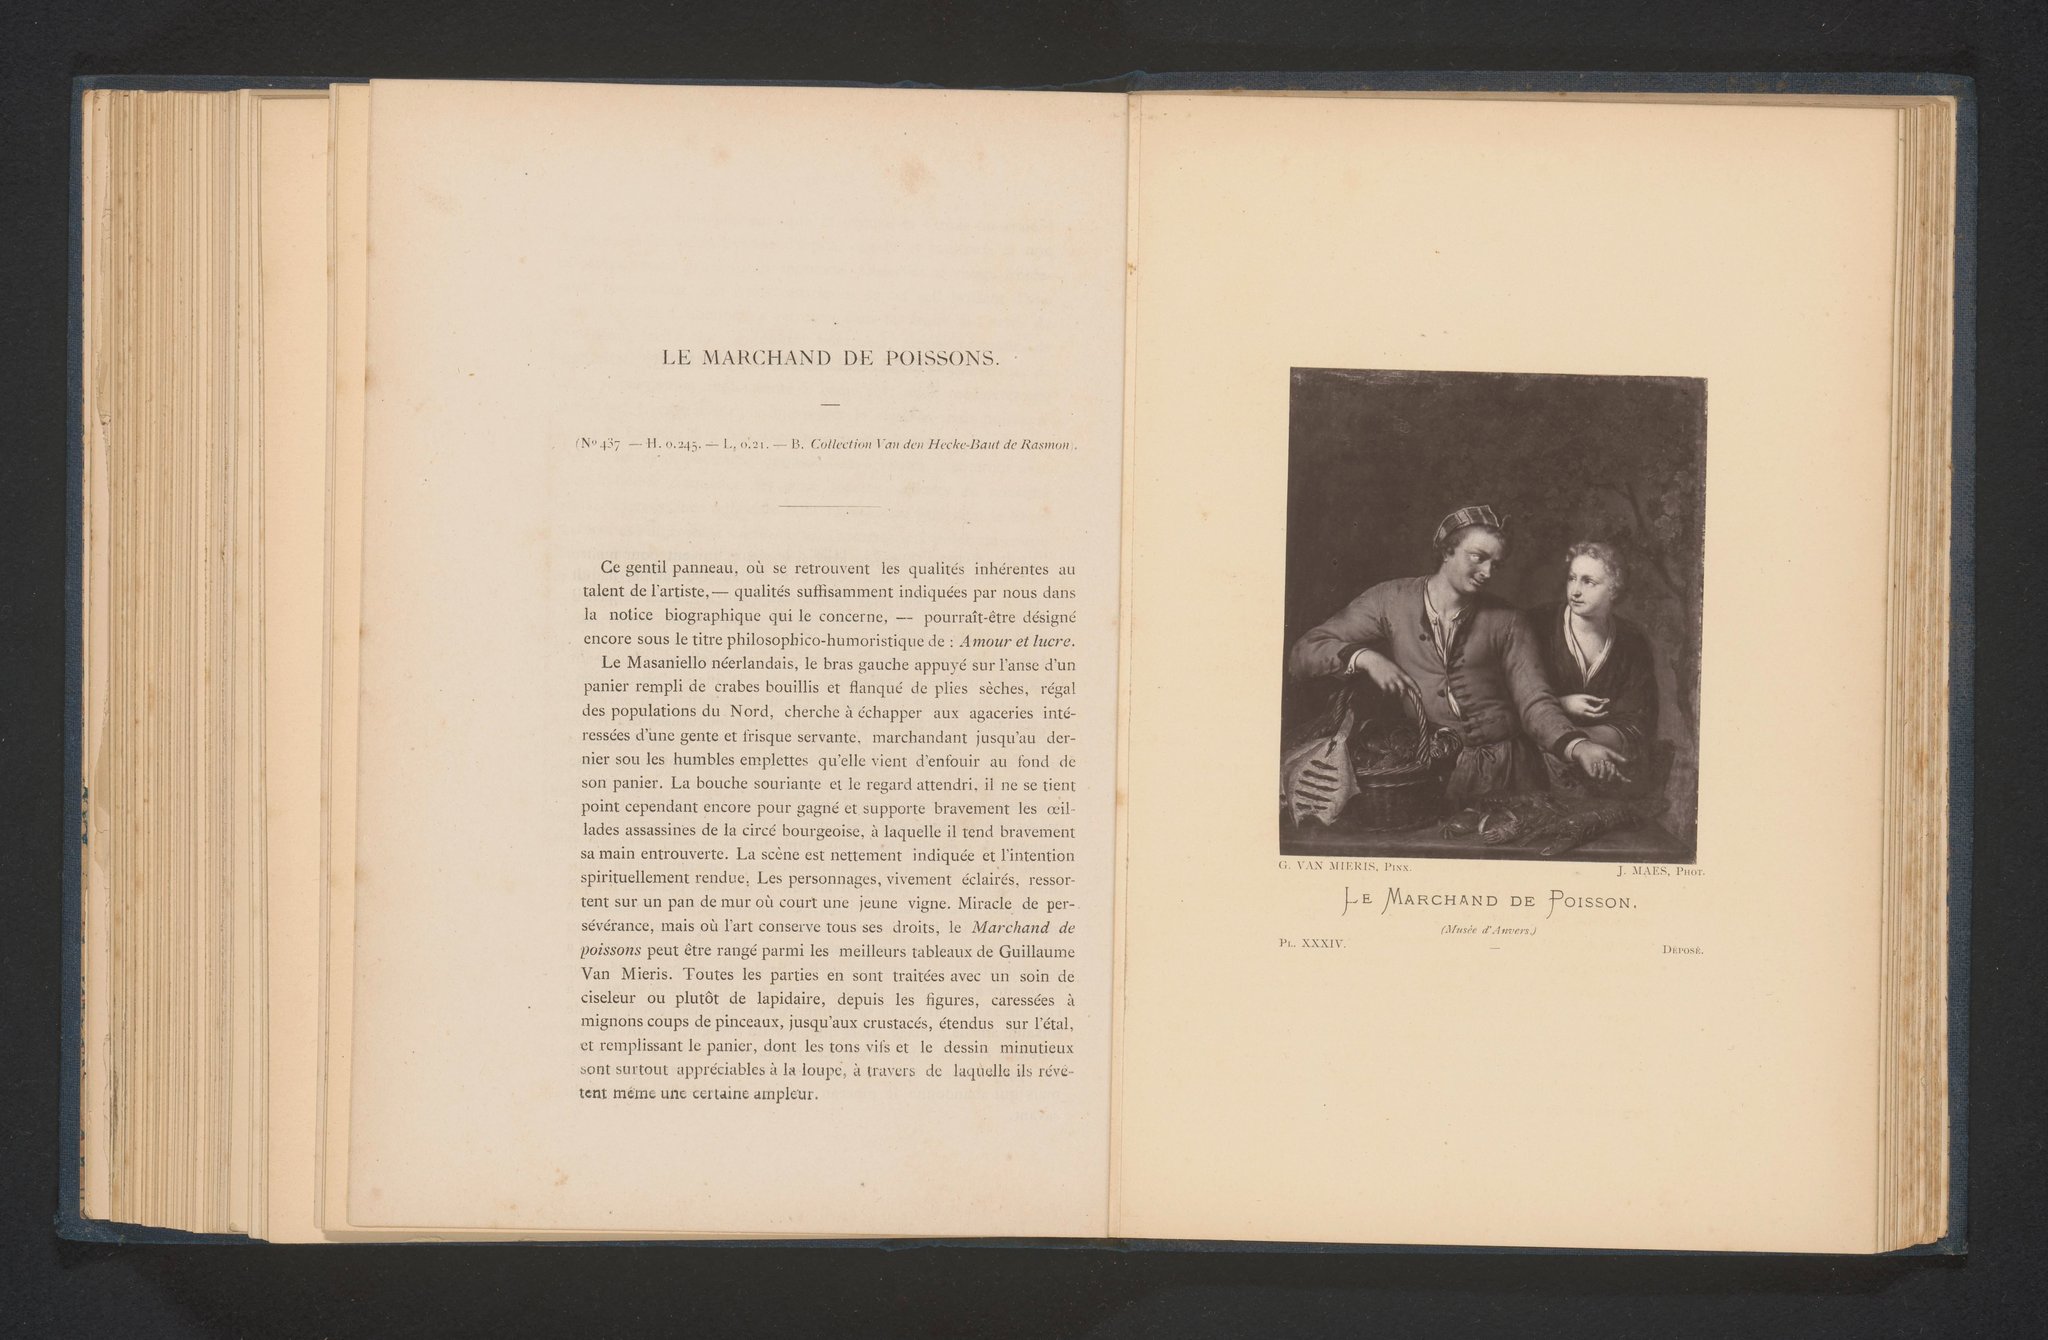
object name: page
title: Le Marchand de Poisson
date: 1872-1877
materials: paper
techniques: woodburytype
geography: antwerp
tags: merchant, salesman (fish)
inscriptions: inscription: ‘(Musée d'Anvers)/ Pl. XXXIV. Déposé.’